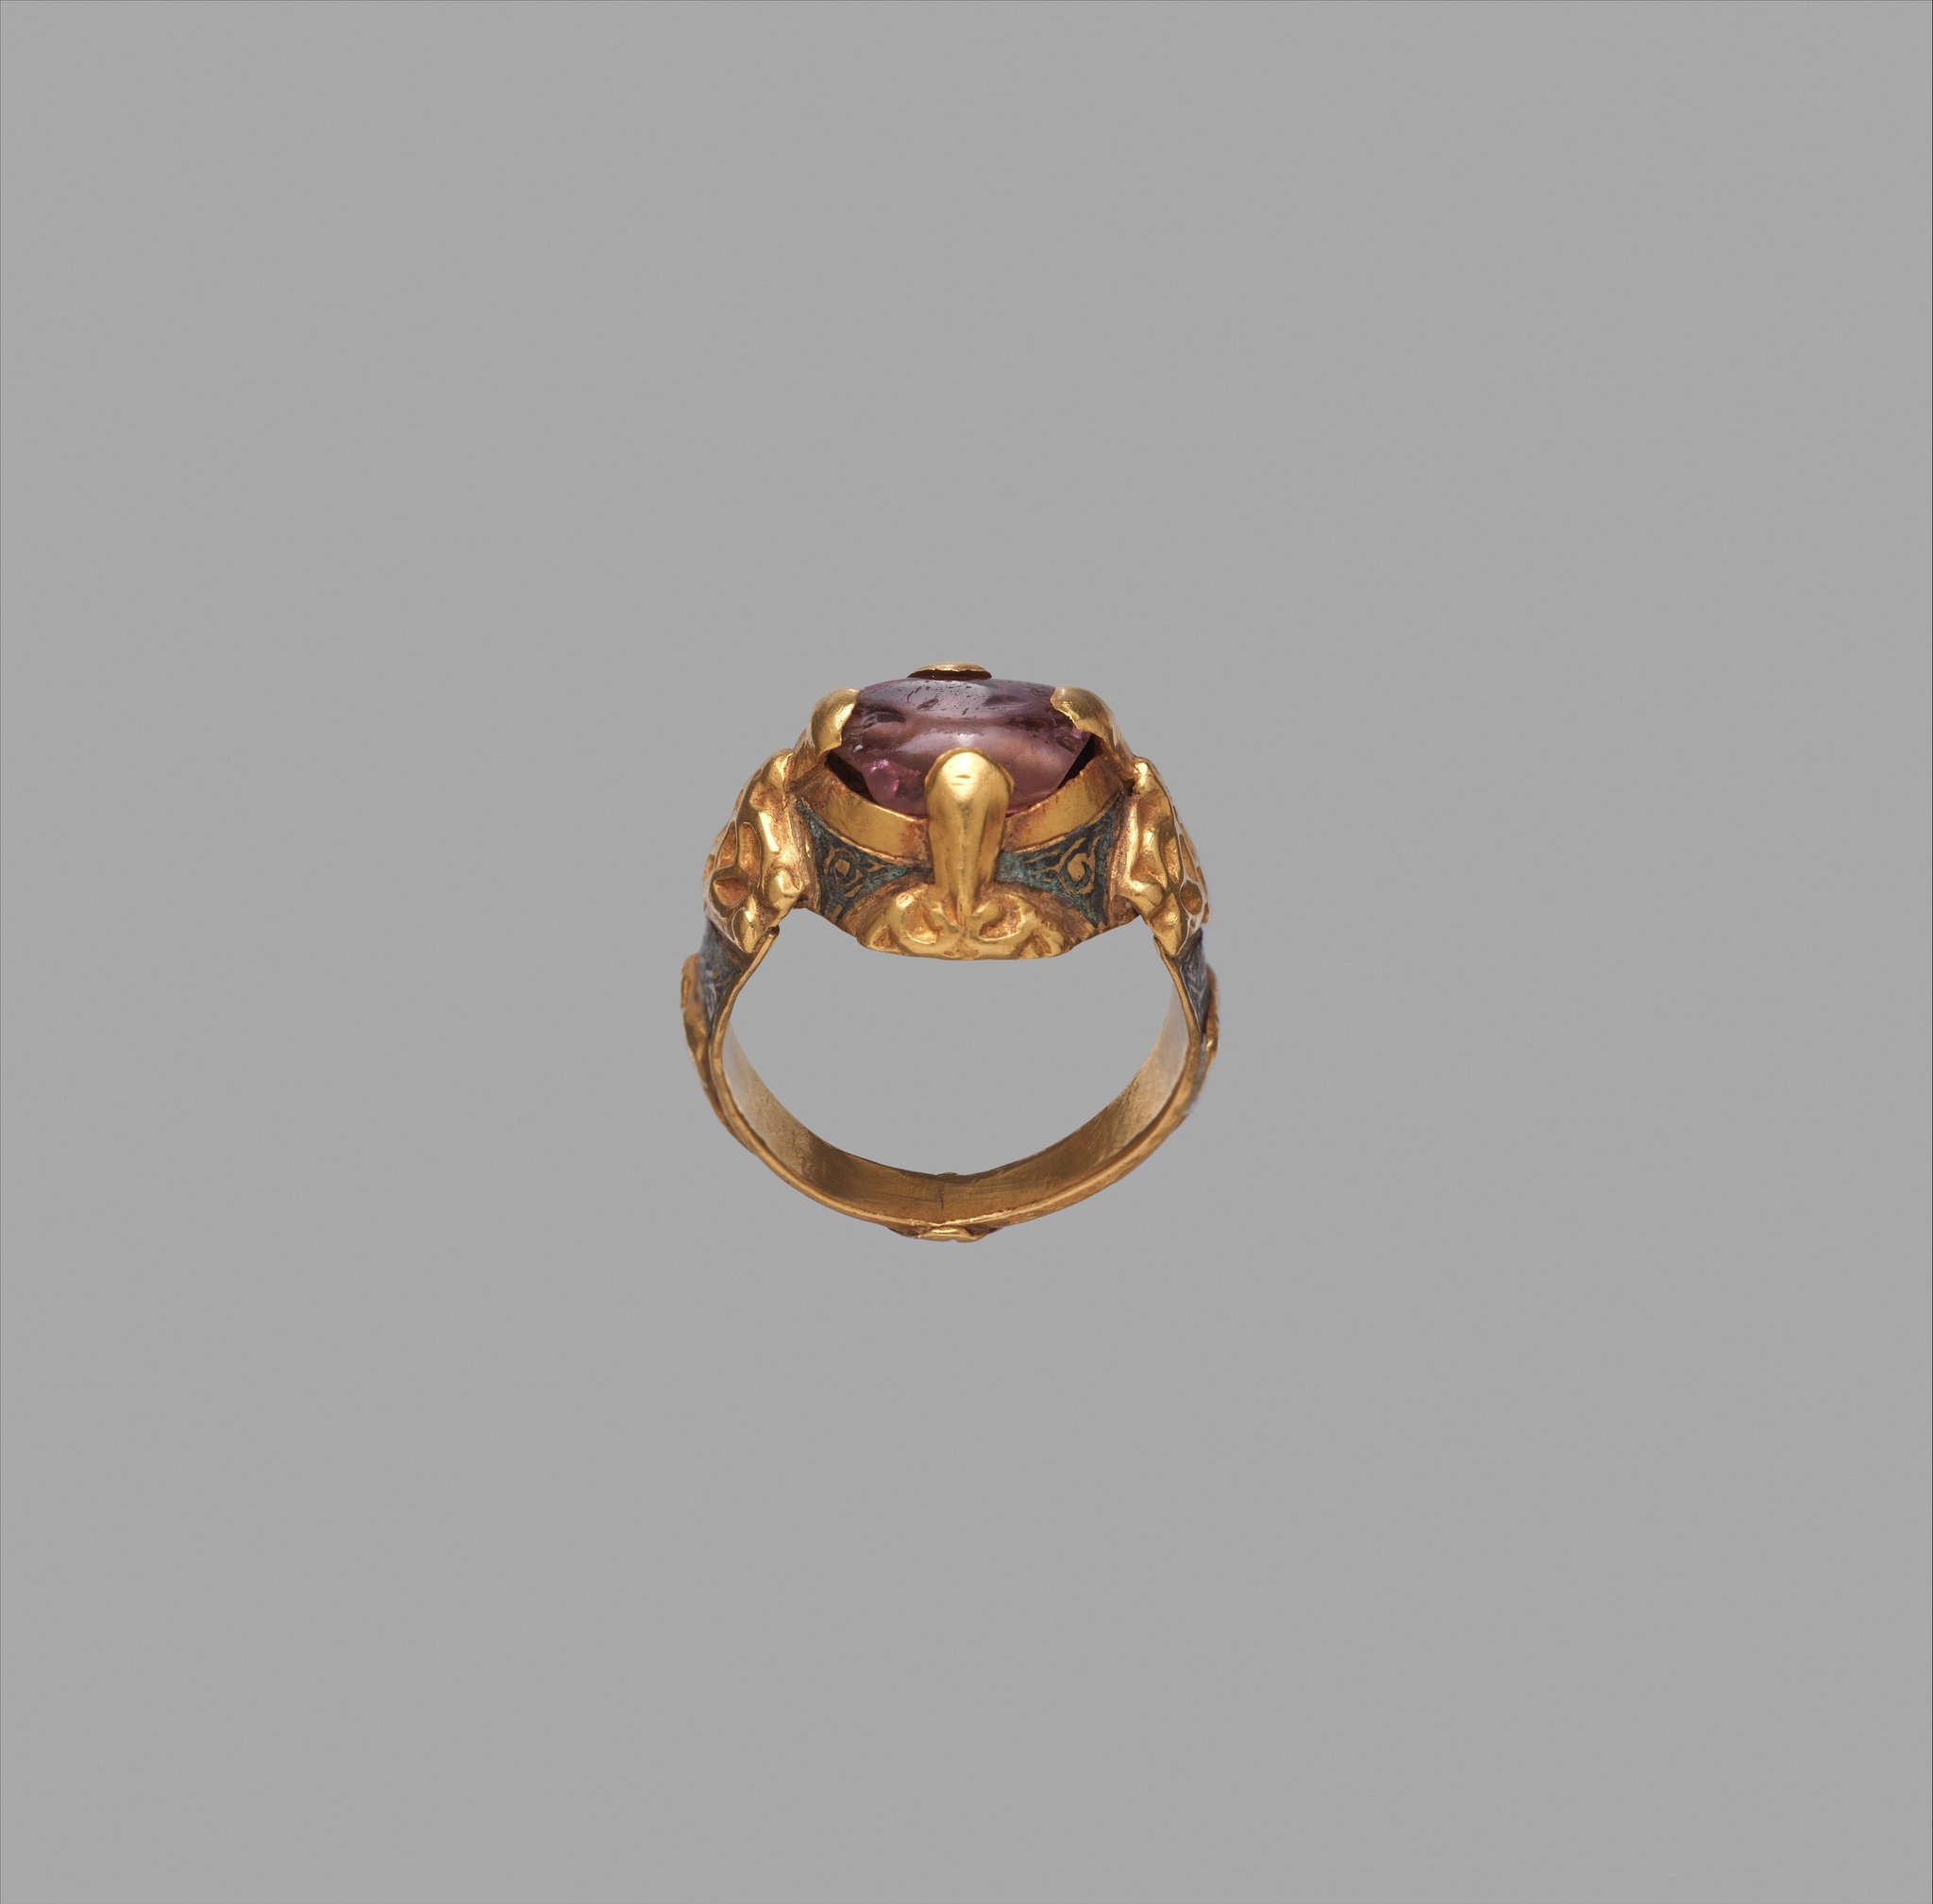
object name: ring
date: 1101-1200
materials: gold, gemstone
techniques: casting, highlighting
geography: iran